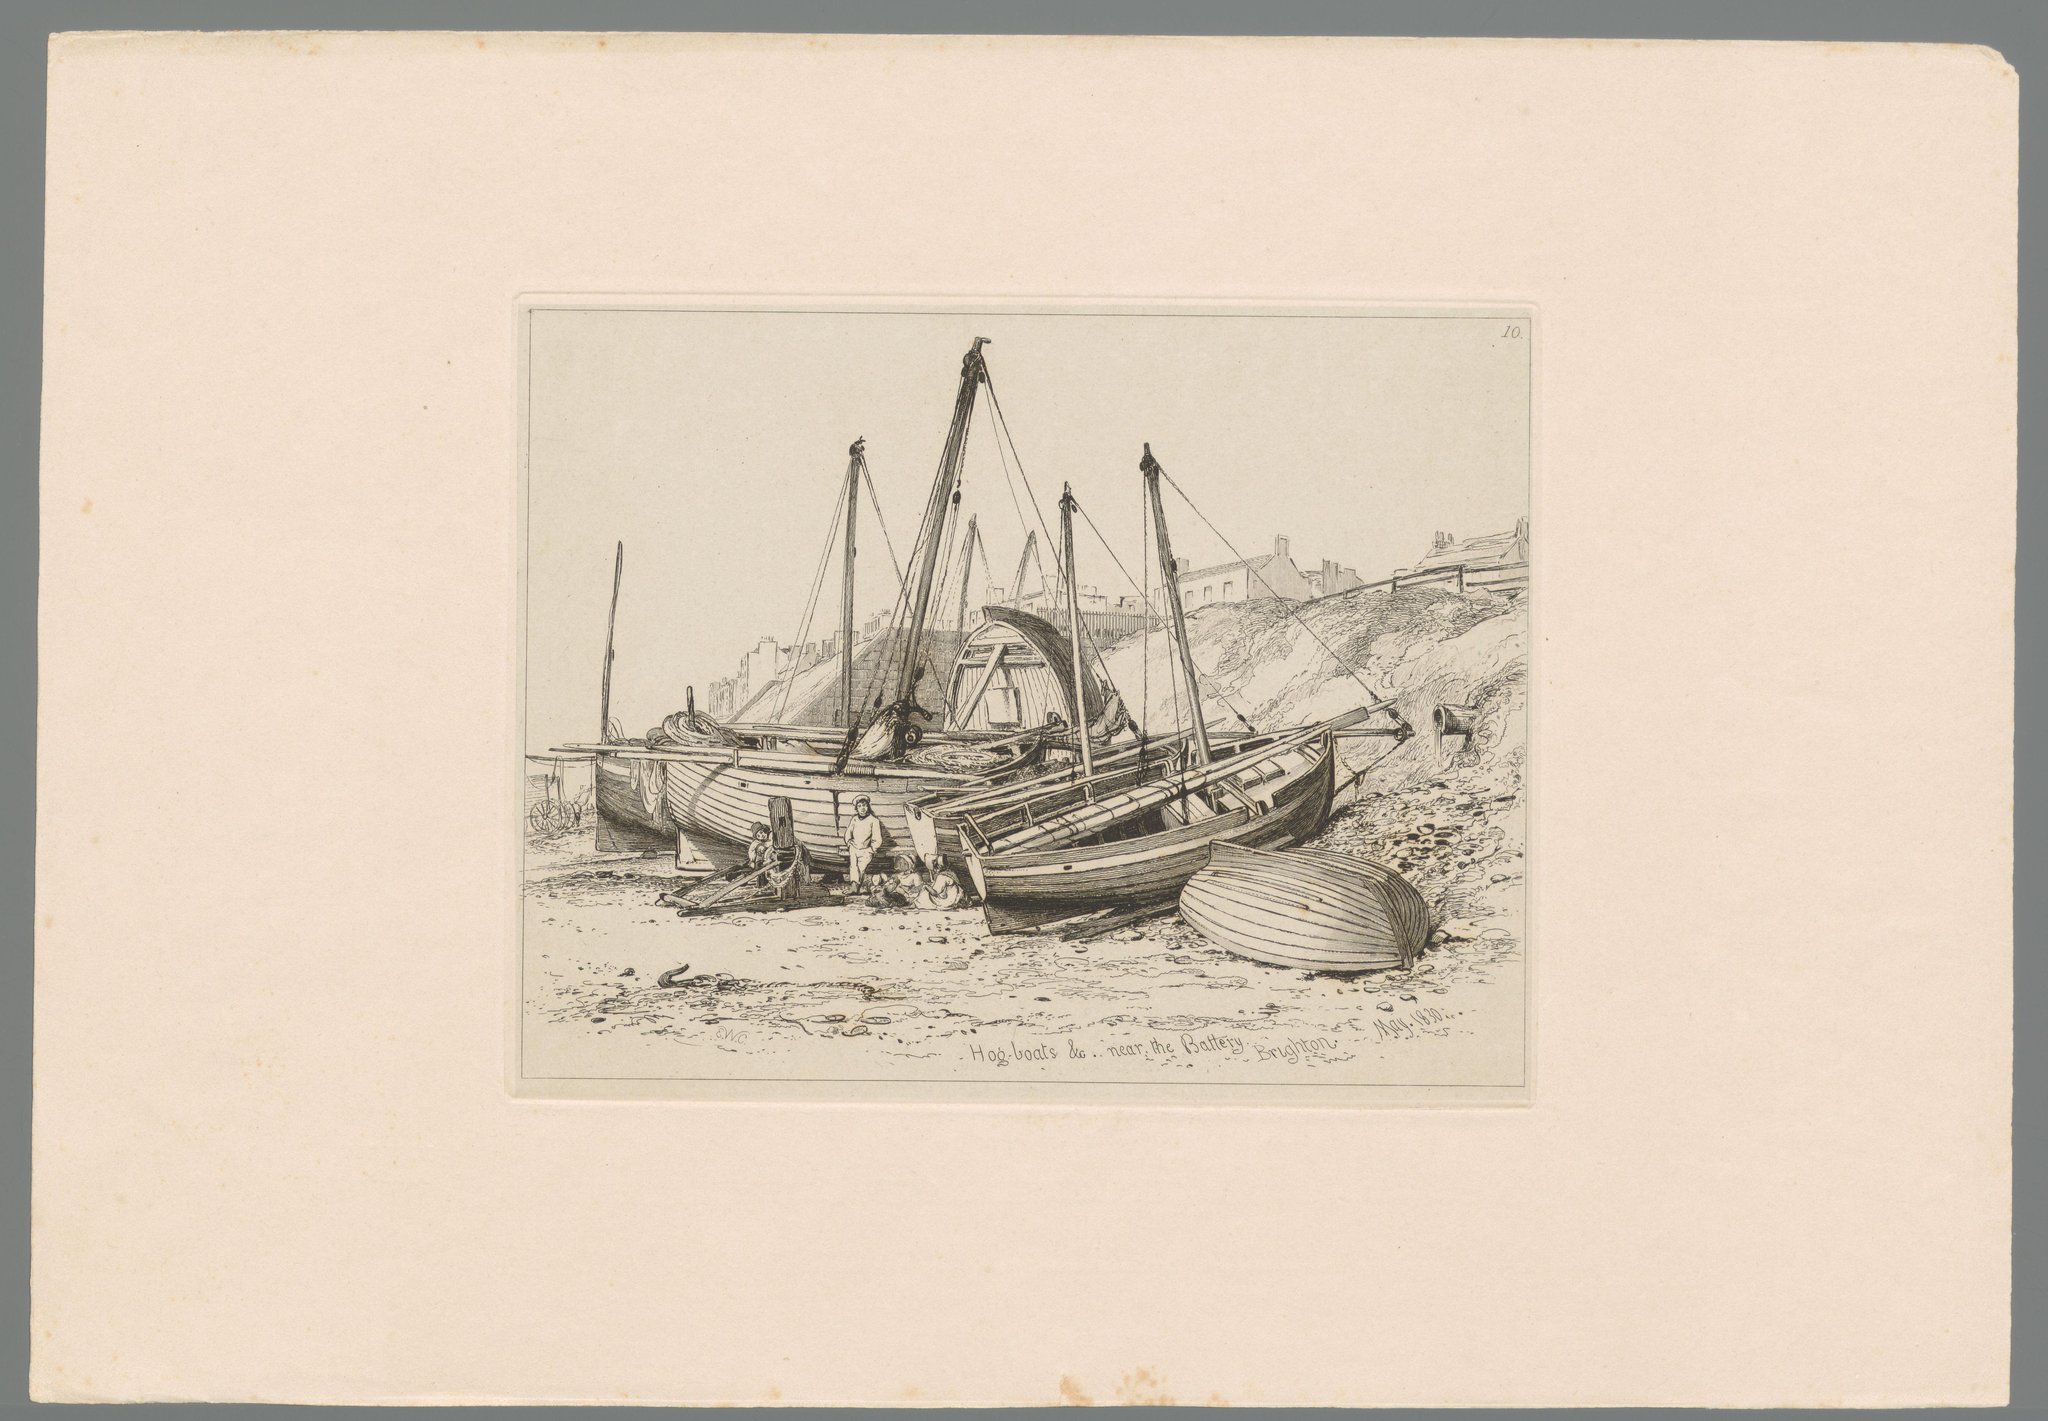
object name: print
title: Vijf figuren bij vissersboten op het strand van Brighton, op de achtergrond huizen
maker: edward william cooke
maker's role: print maker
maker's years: 1811-1880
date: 1805-1830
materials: paper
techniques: etching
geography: england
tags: urban housing, sailing-ship, sailing-boat, beach (+ landscape with figures, staffage)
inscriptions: collector's mark: Lugt 2165